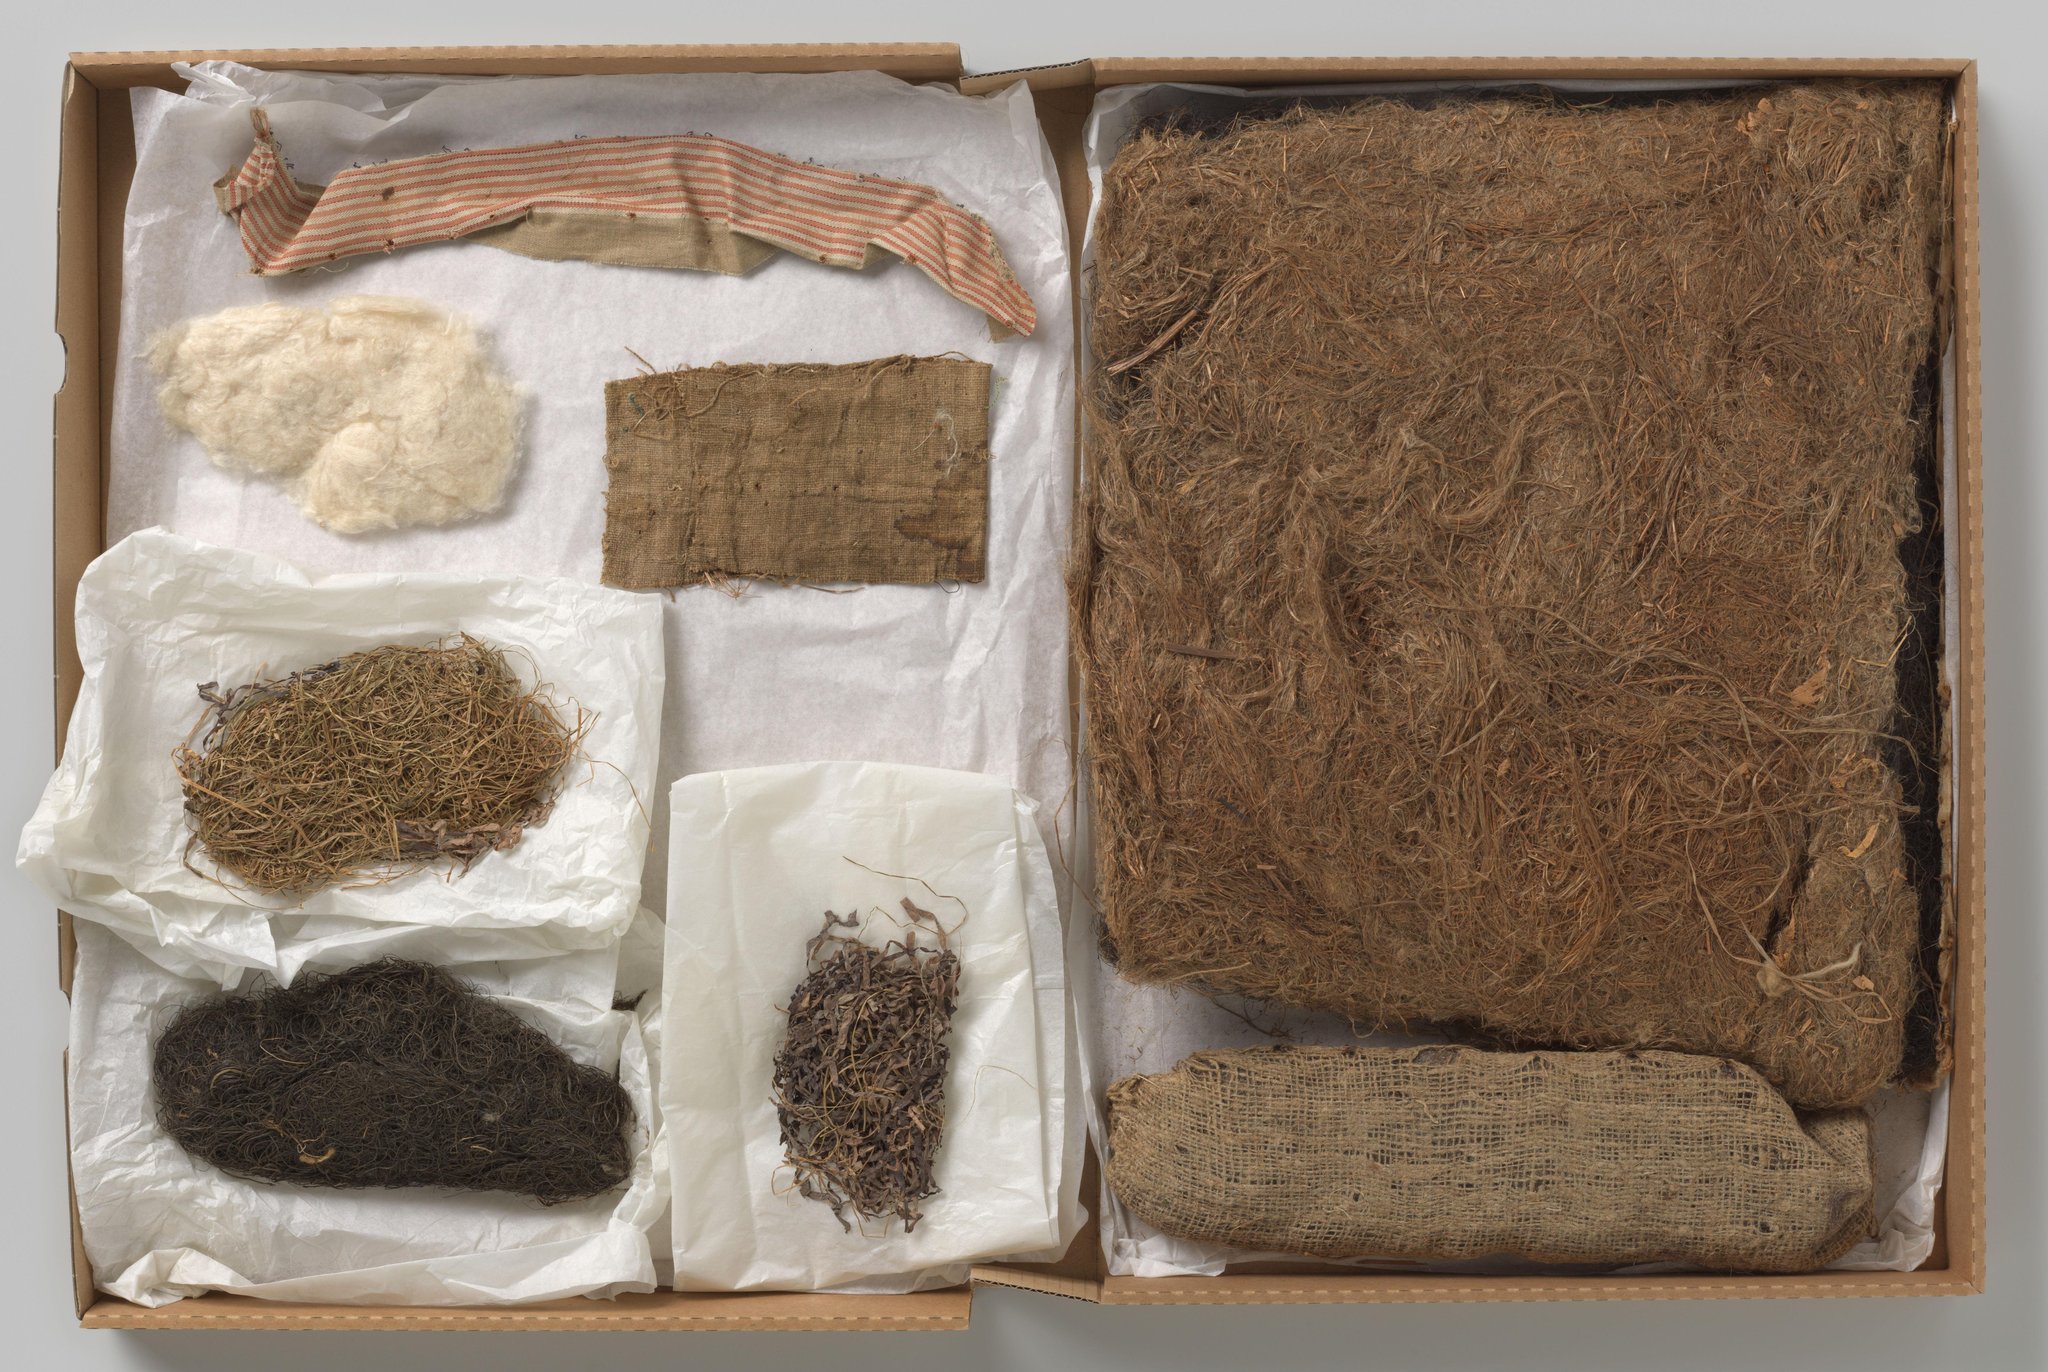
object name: stoelleuning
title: Vulling van een armstoelbekleding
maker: Anonymous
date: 1785-1800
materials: cotton, hair, jute, wool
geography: northern netherlands